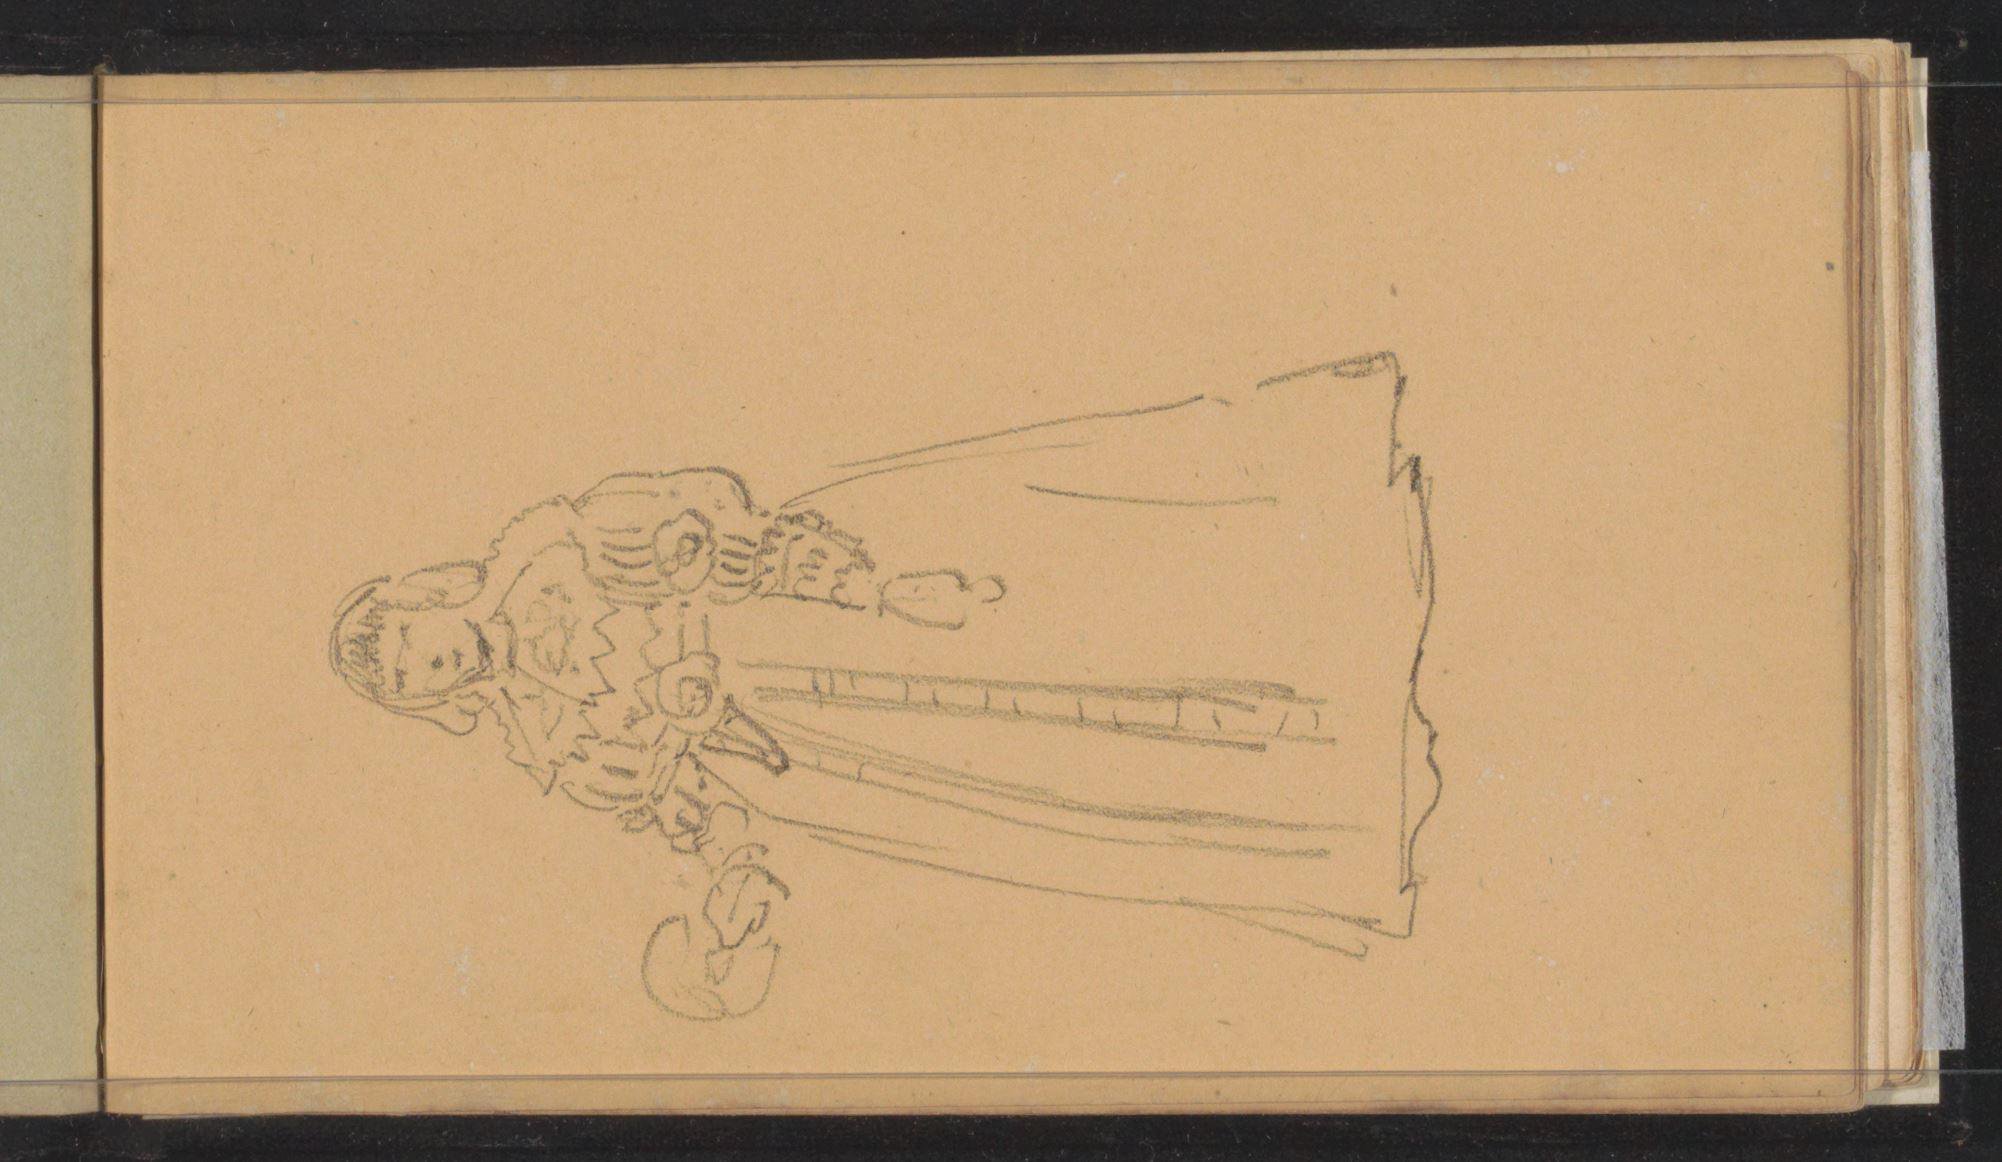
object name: sketchbook leaf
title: Vrouw in een jurk met pofmouwen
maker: cornelis springer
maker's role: draughtsman, painter, print maker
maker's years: 1817-1891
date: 1860-1866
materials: paper, pencil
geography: netherlands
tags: adult woman, fan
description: Vrouw in een jurk met pofmouwen. Ze heeft mogelijk een waaier in haar hand. Blad 33 uit een schetsboek met 44 bladen.